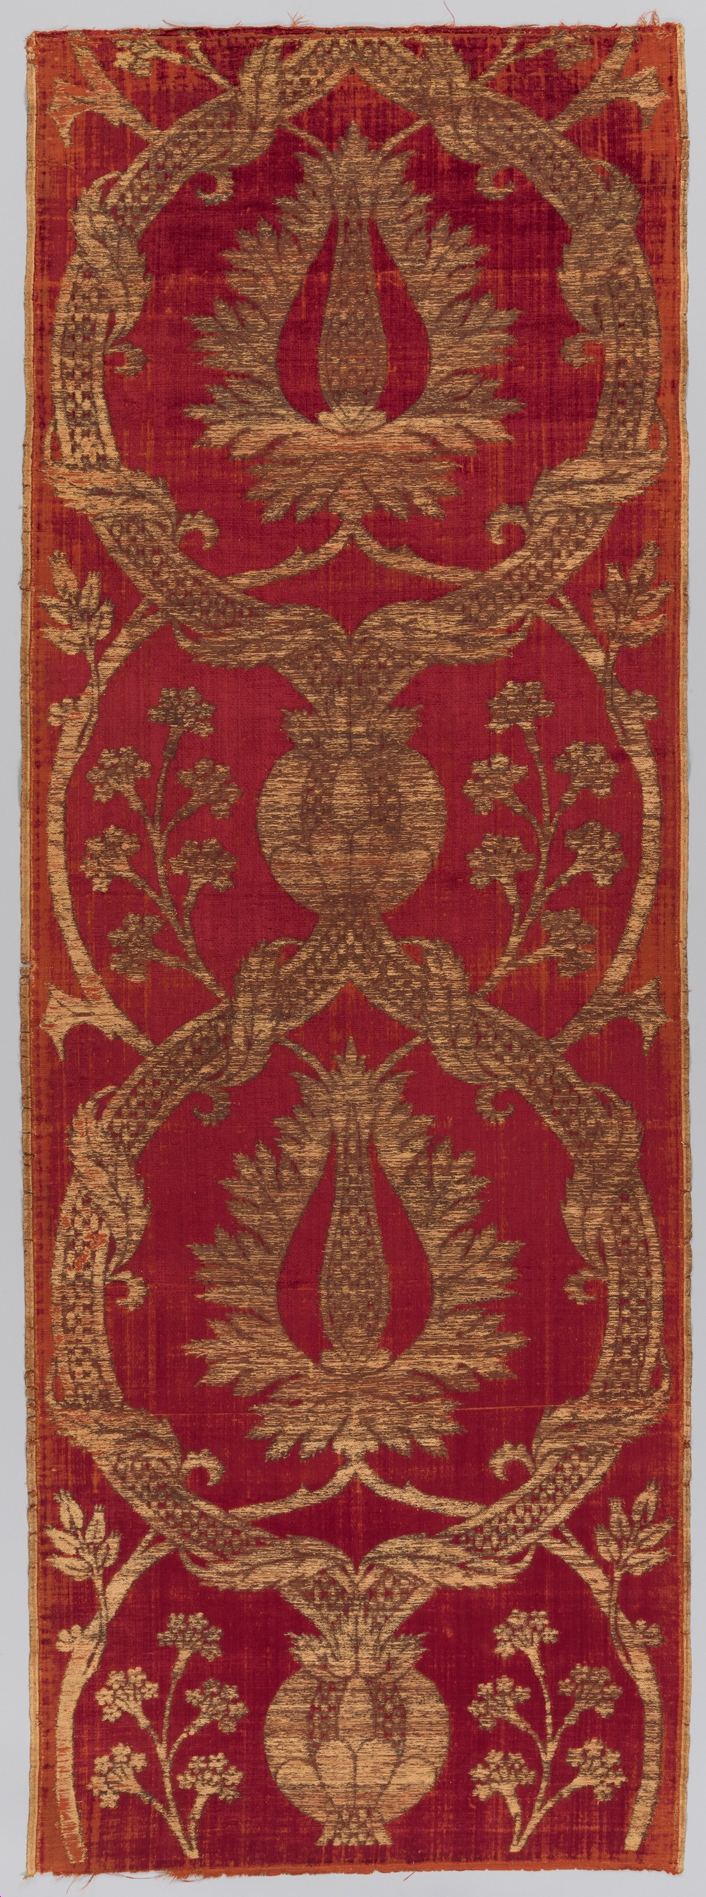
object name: panel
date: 1501-1600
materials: metal thread, silk, velvet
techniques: brocade, cutting, voiding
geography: turkey